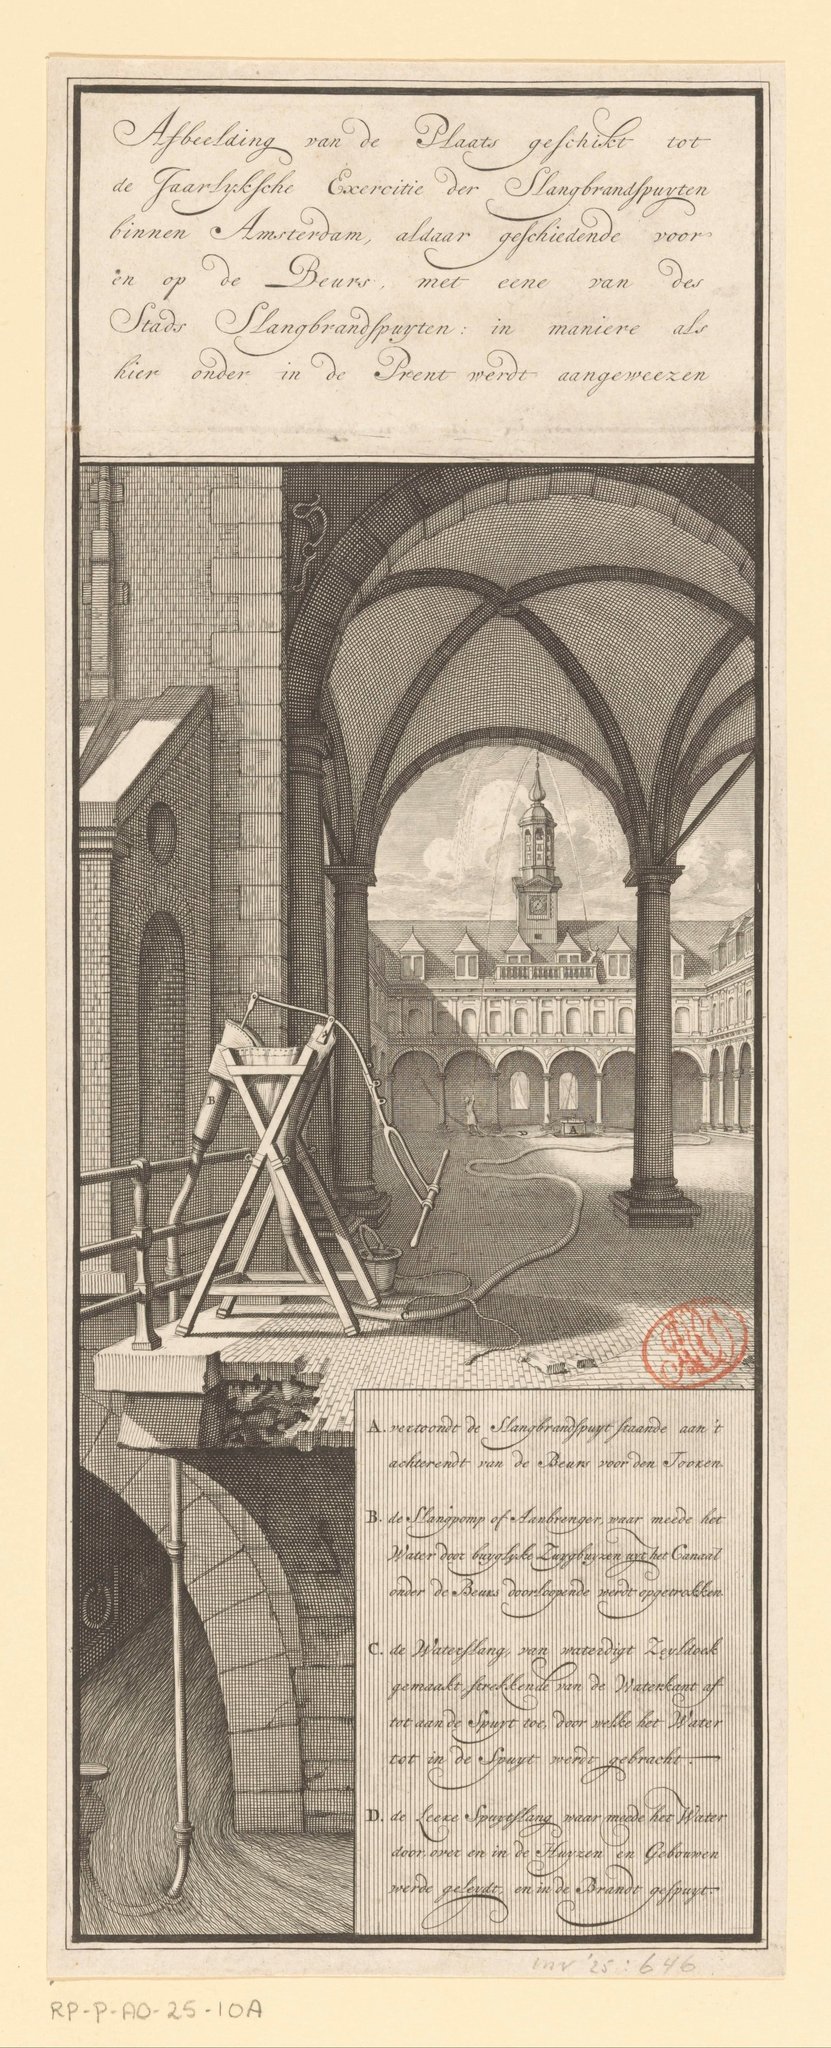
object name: book illustration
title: Demonstratie van de slangbrandspuiten op het binnenplein van de Beurs te Amsterdam, ca. 1670-1680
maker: laurens scherm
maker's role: draughtsman, print maker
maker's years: 1671-1702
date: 1690-1702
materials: paper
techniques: engraving, etching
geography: amsterdam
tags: amsterdam, draughtsman, jan van der heyden, pump (fire-extinguishing equipment), exchange, bourse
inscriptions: collector's mark: Lugt 195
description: Demonstratie van het gebruik van de slangbrandspuiten door het oppompen van water en over het torentje van de Beurs heen te spuiten (ca. 1670-1680). In het onderschrift de verklaring van de letters A-D in het Nederlands. Boven de plaat is een tweede plaat met tekst afgedrukt. Plaat 23 in de herdruk van het Brandspuitenboek van Jan van der Heyden uit 1735.